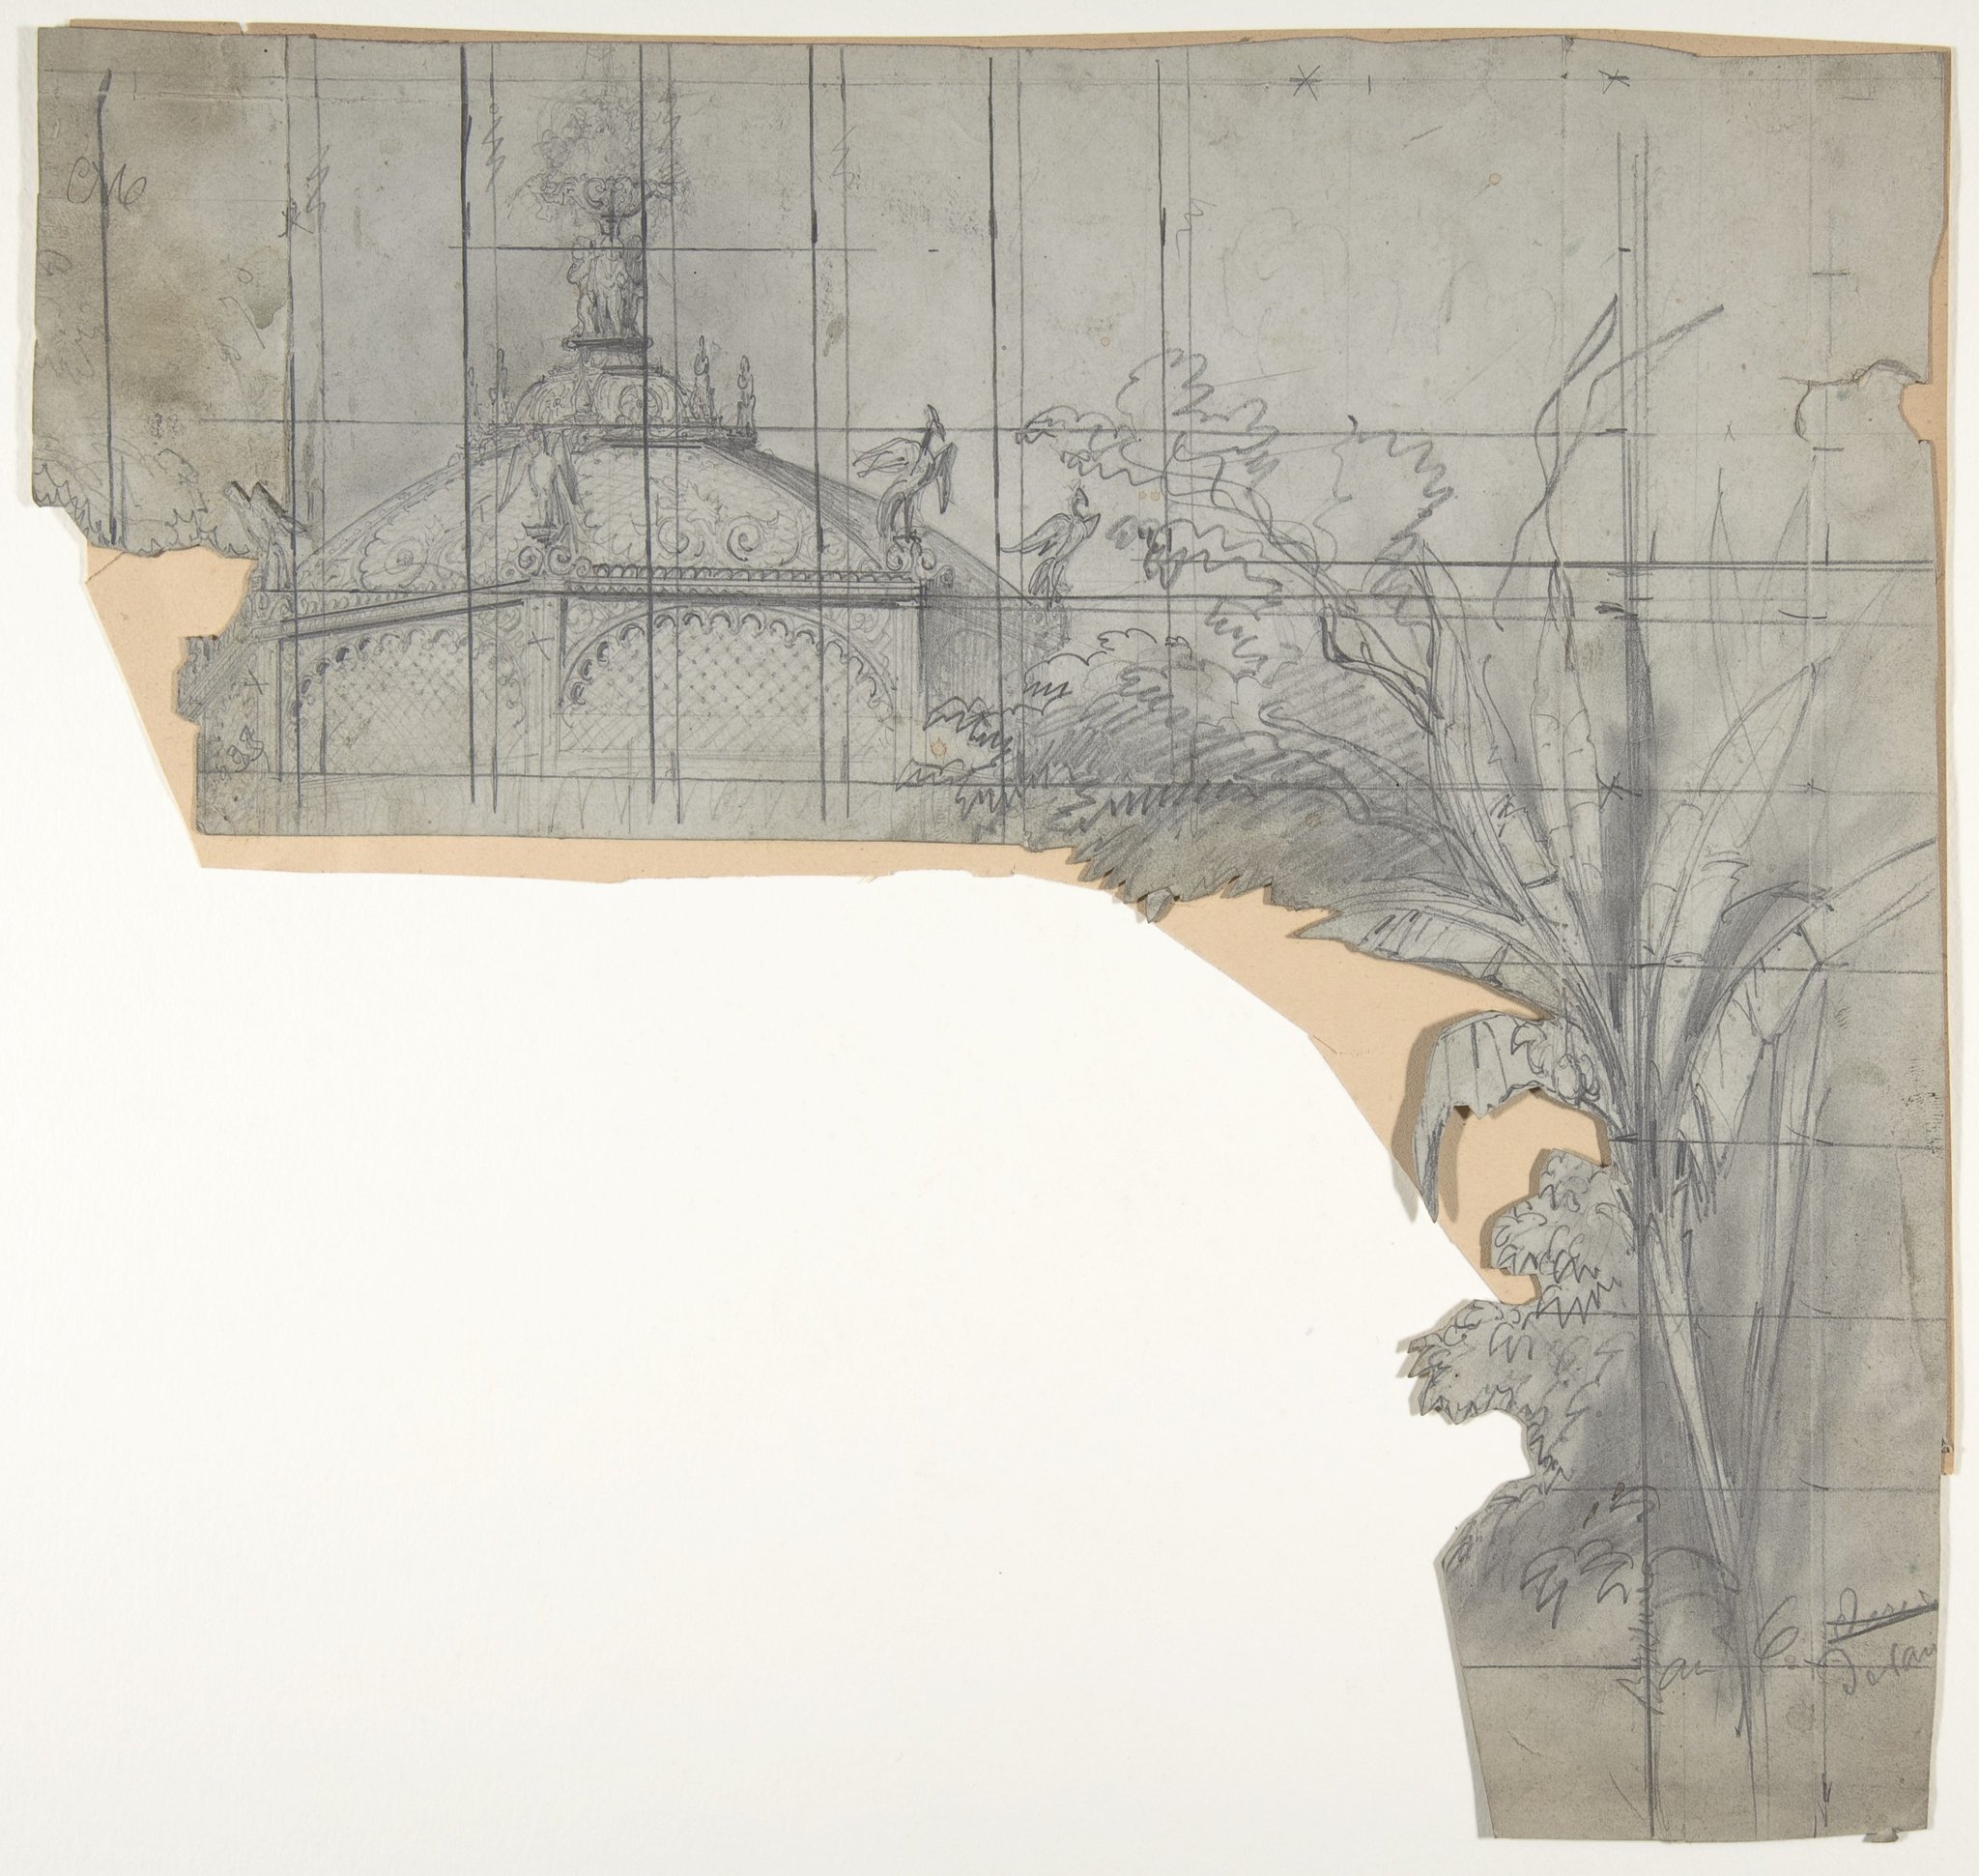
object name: drawing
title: Design for a Stage Set at the Opéra, Paris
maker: eugène cicéri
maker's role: artist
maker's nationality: french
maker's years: 1813-1890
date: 1830-1890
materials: graphite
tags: stage design